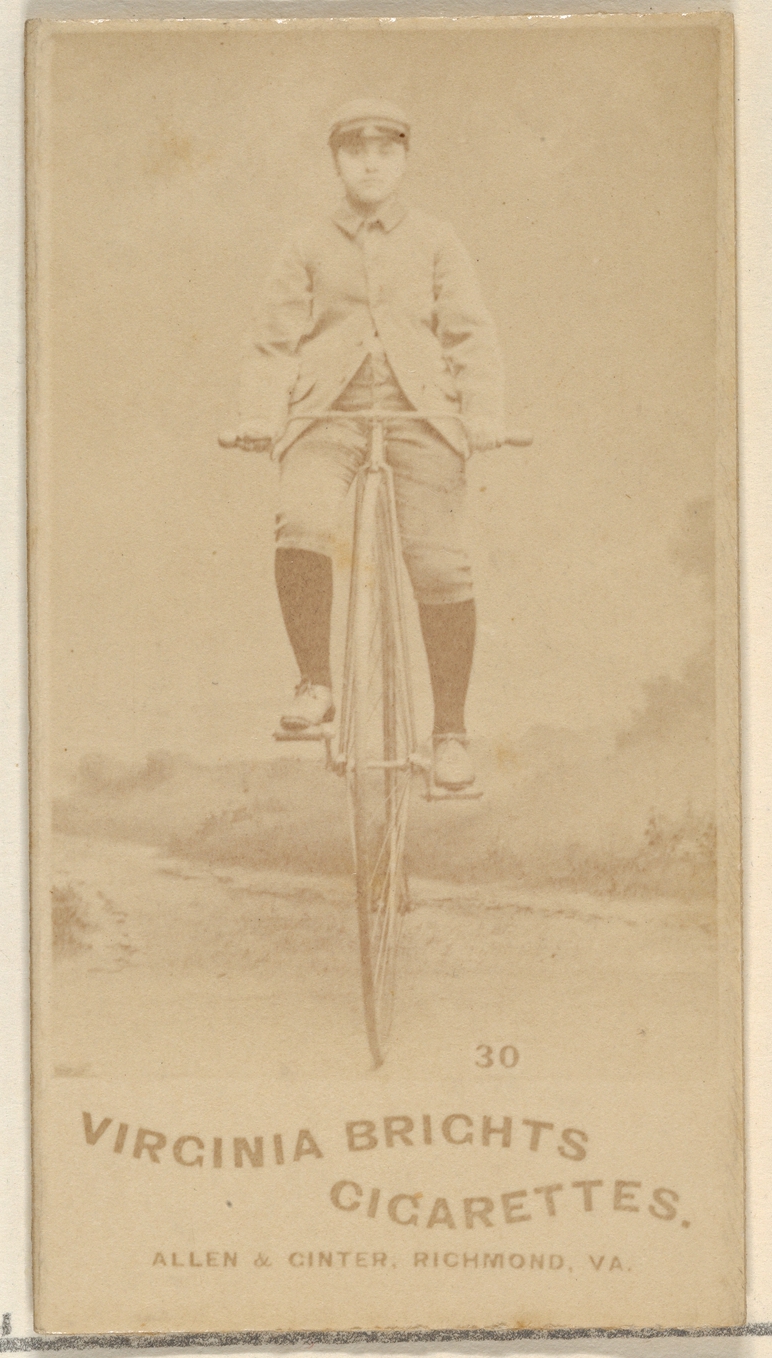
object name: photograph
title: Card 30, from the Girl Cyclists series (N49) for Virginia Brights Cigarettes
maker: allen & ginter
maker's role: publisher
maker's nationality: american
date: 1887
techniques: albumen silver print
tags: girls,portraits,bicycles